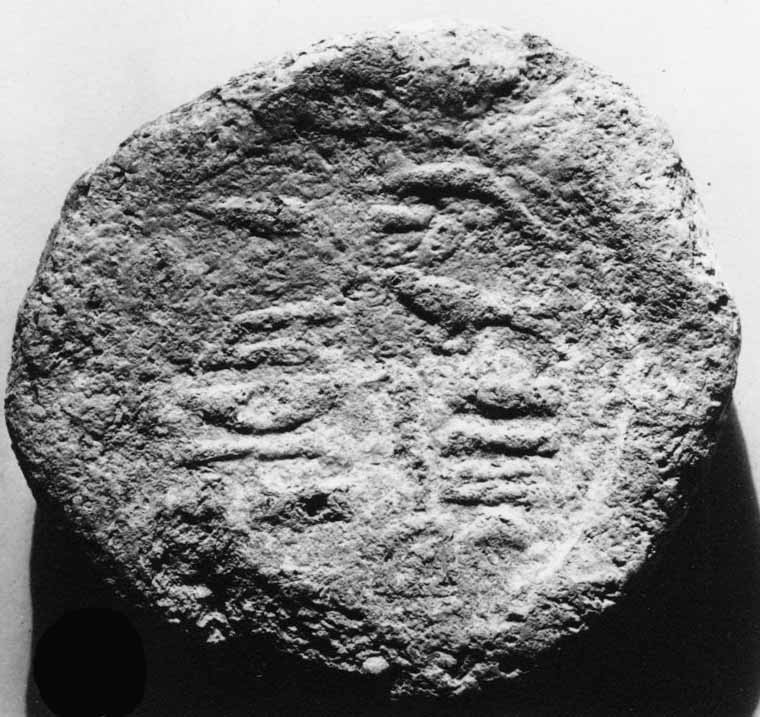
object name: cone, amenemipet, circular impression, steward, festival leader, amun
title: Funerary Cone of the Chief Steward Amenemopet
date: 1550-1295 BCE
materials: pottery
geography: egypt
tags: hieroglyphs